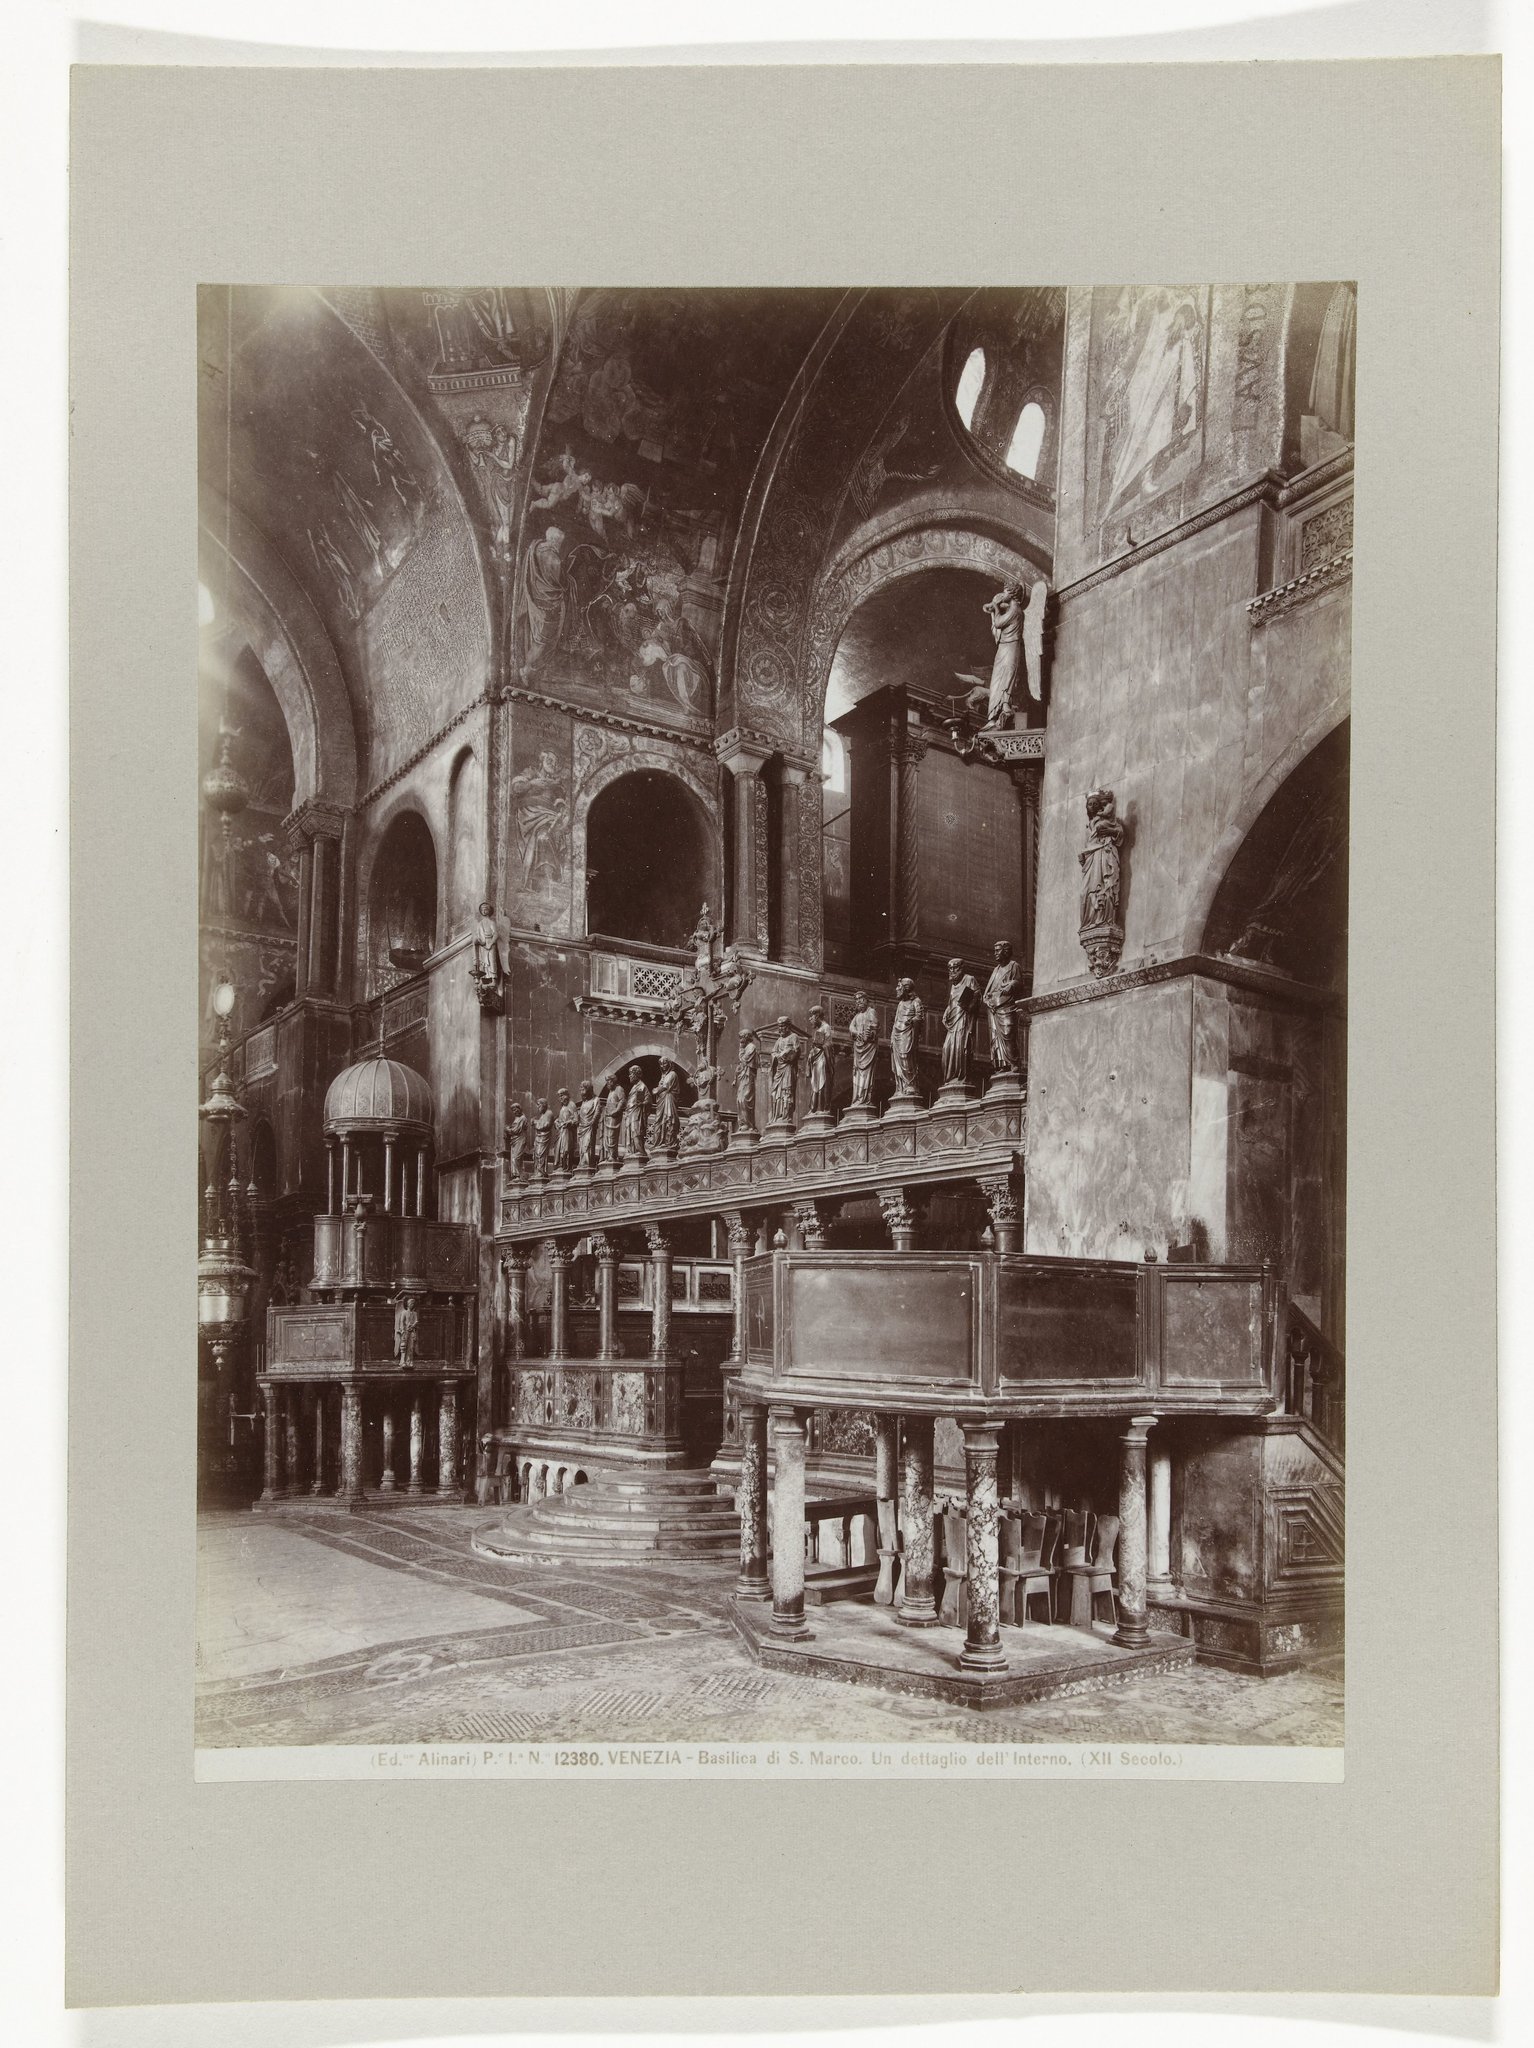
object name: photograph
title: Interieur van de San Marco, Venetië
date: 1880-1895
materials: cardboard, paper, photographic support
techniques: albumen print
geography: florence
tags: interior of church, venice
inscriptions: number: ‘107.’